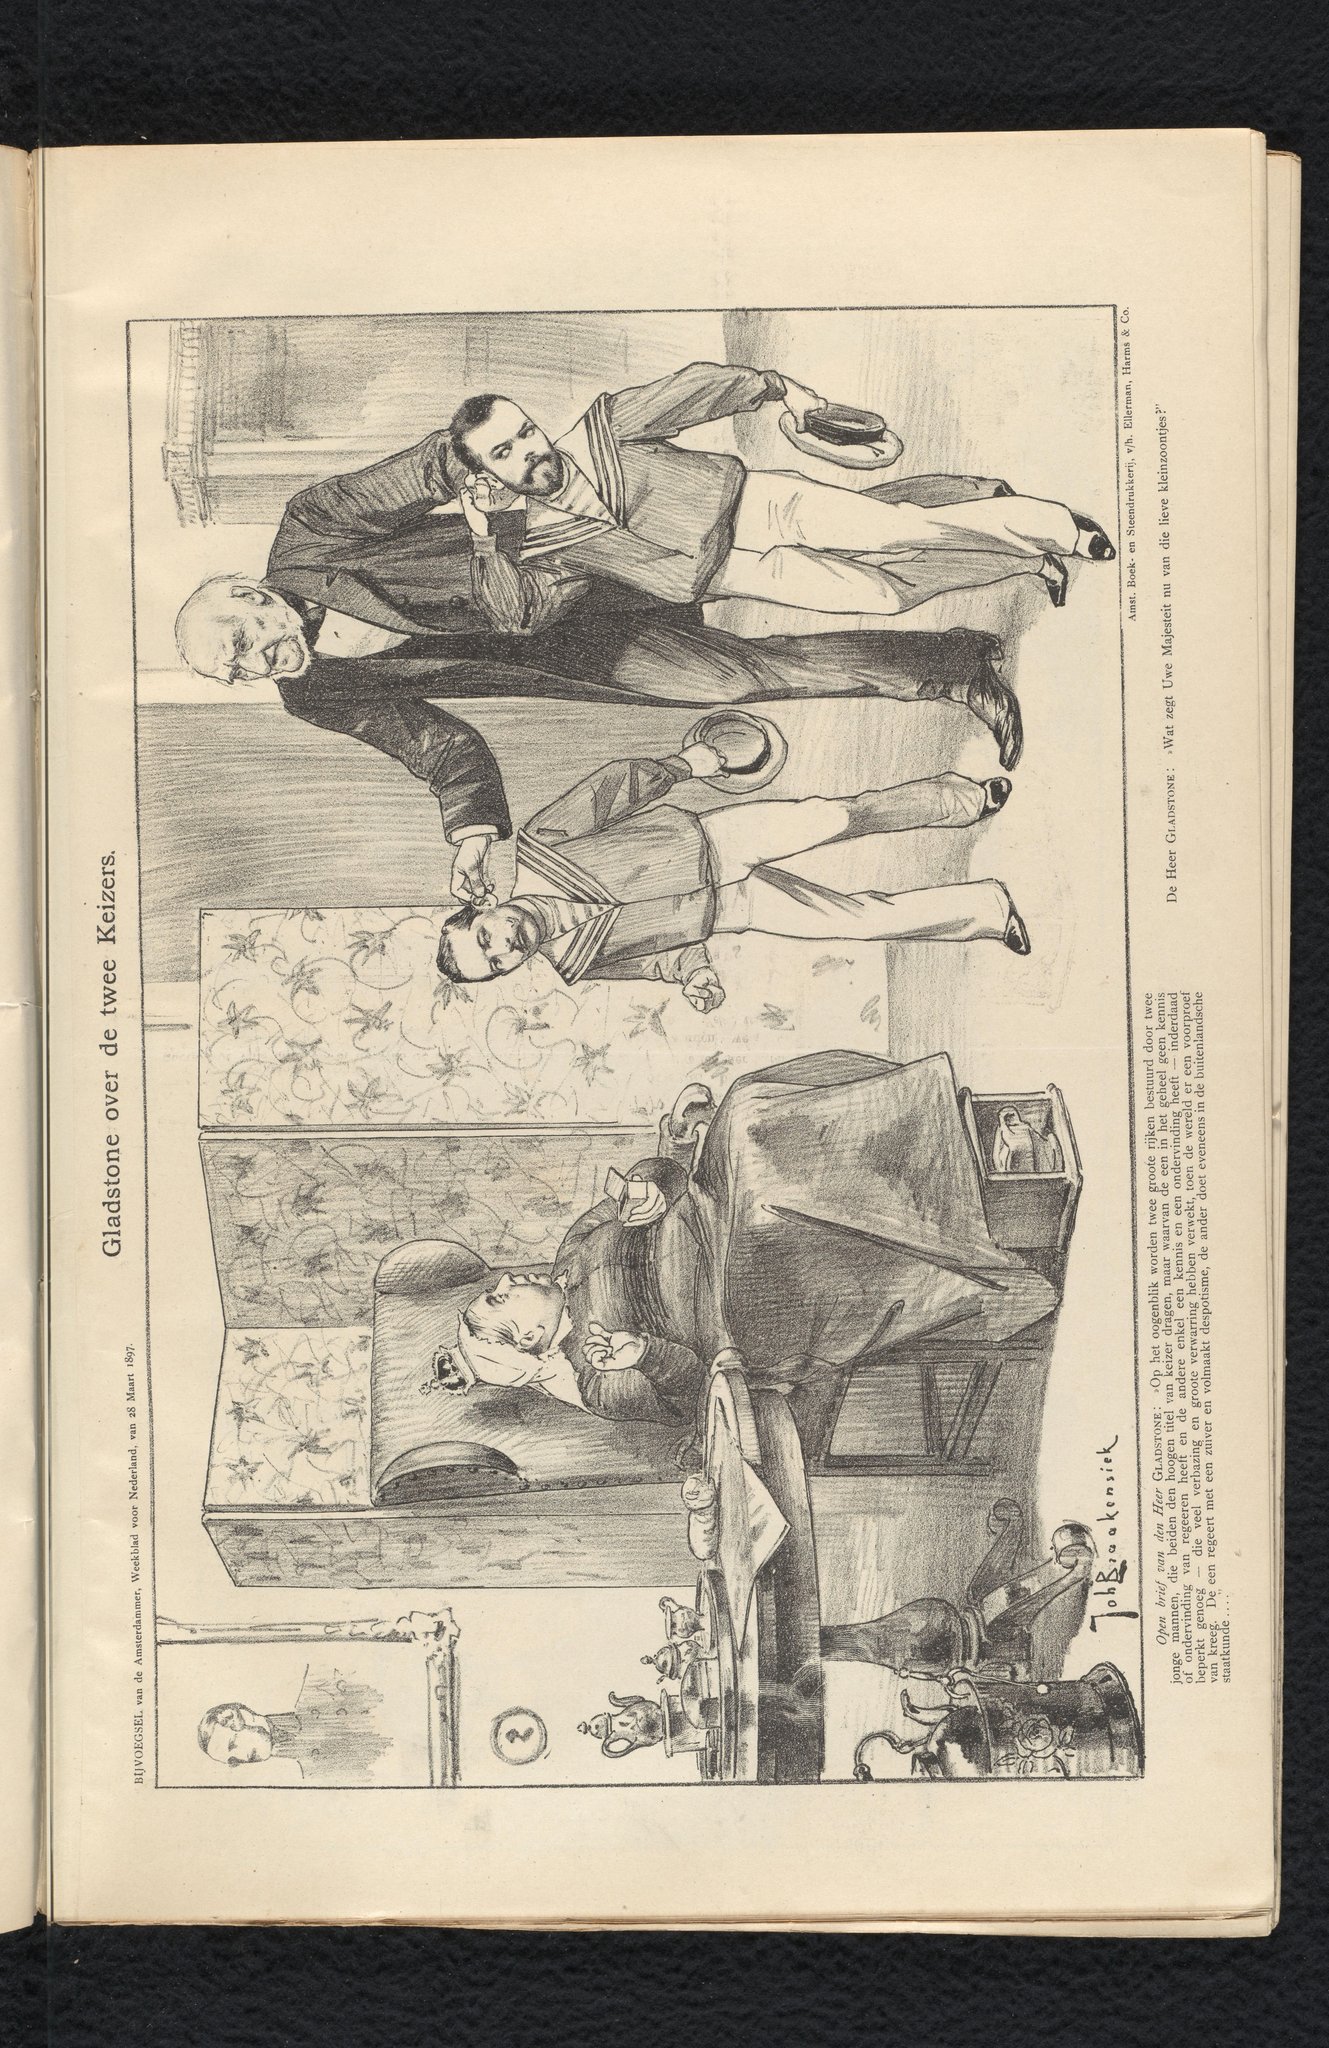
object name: cartoon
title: Gladstone over de twee Keizers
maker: johan braakensiek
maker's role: draughtsman, print maker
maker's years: 1858-1940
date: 1897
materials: paper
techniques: lithograph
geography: netherlands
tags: victoria (koningin van het verenigd koninkrijk en keizerin van india), wilhelm ii (keizer van duitsland), liverpool, correction of naughty children, personifications of countries, nations, states, districts, etc., political caricatures and satires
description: Premier Gladstone brengt de Duitse en Russische keizers als kwajongens aan hun oren bij hun oma koningin Victoria.